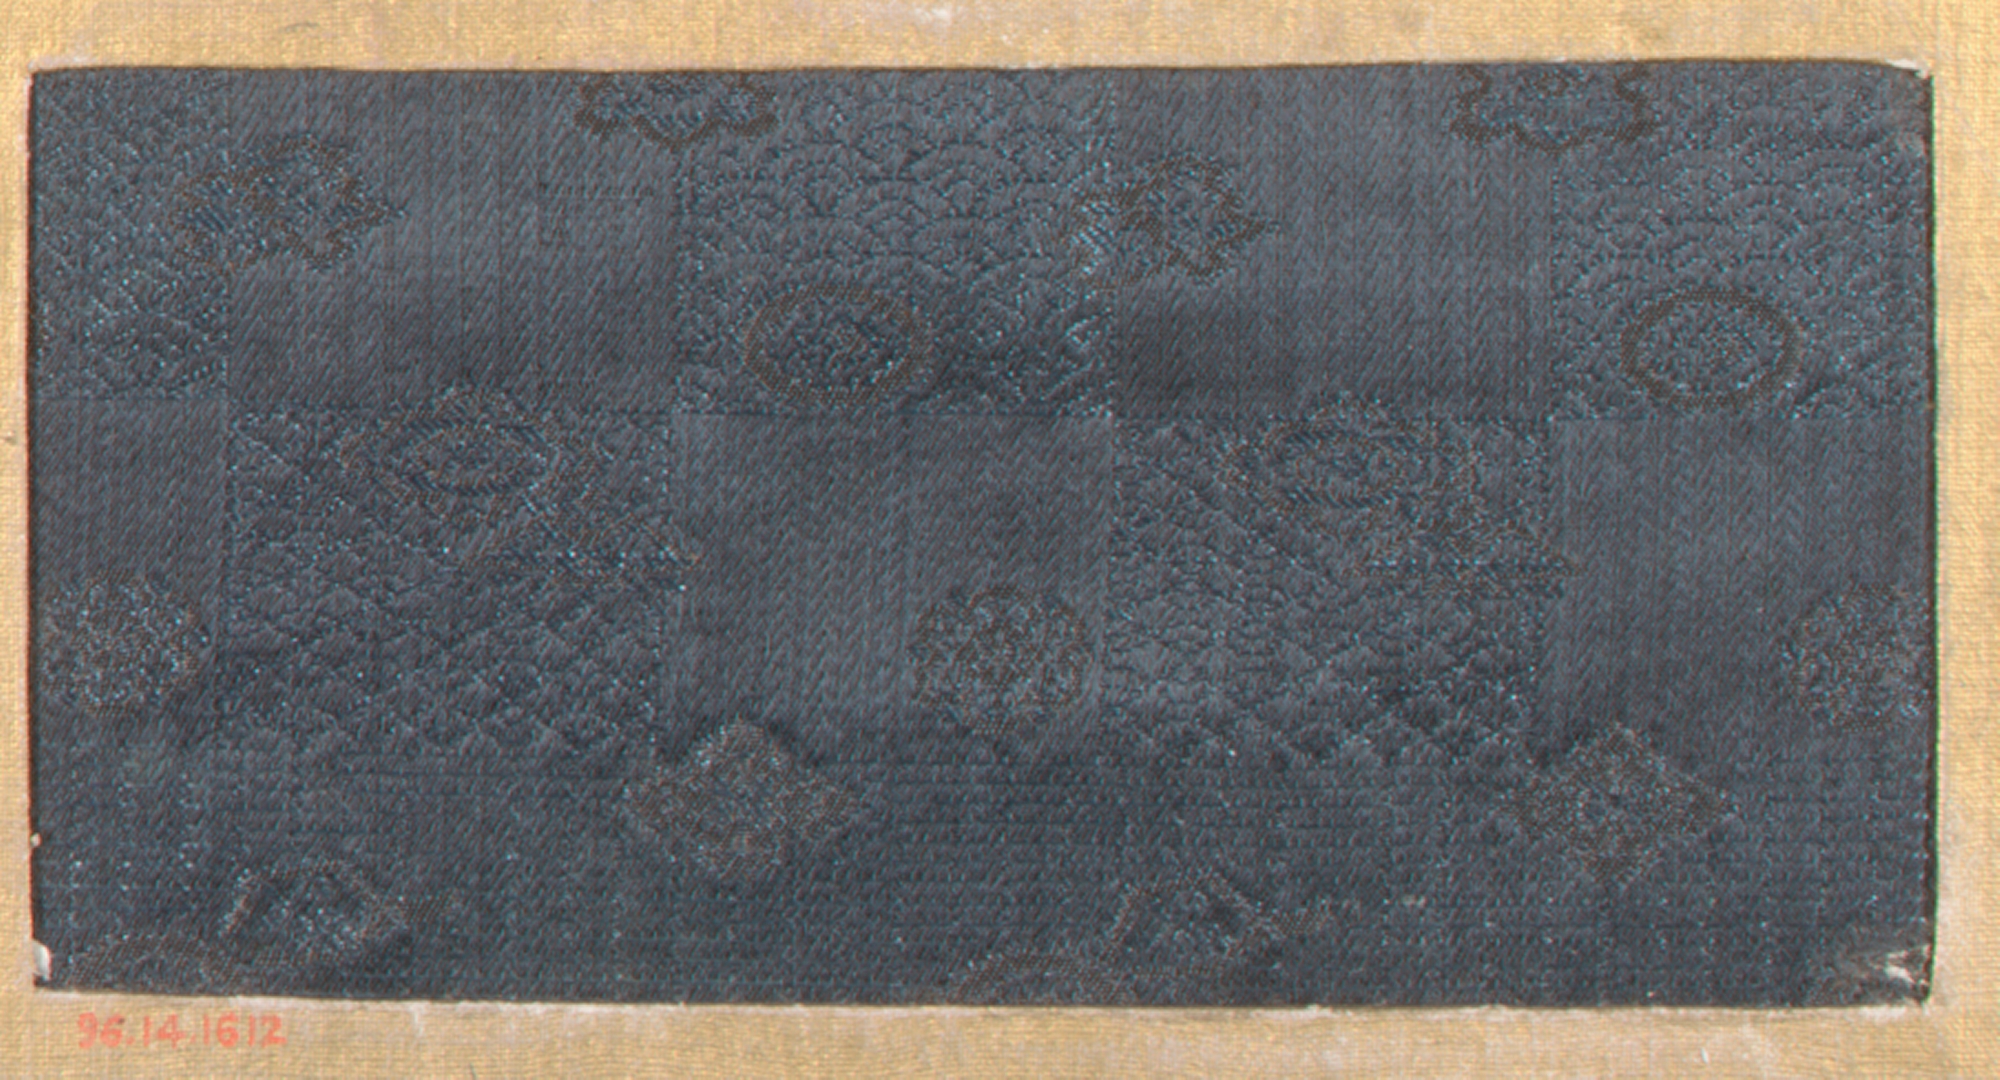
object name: piece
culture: japanese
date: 1701-1900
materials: silk